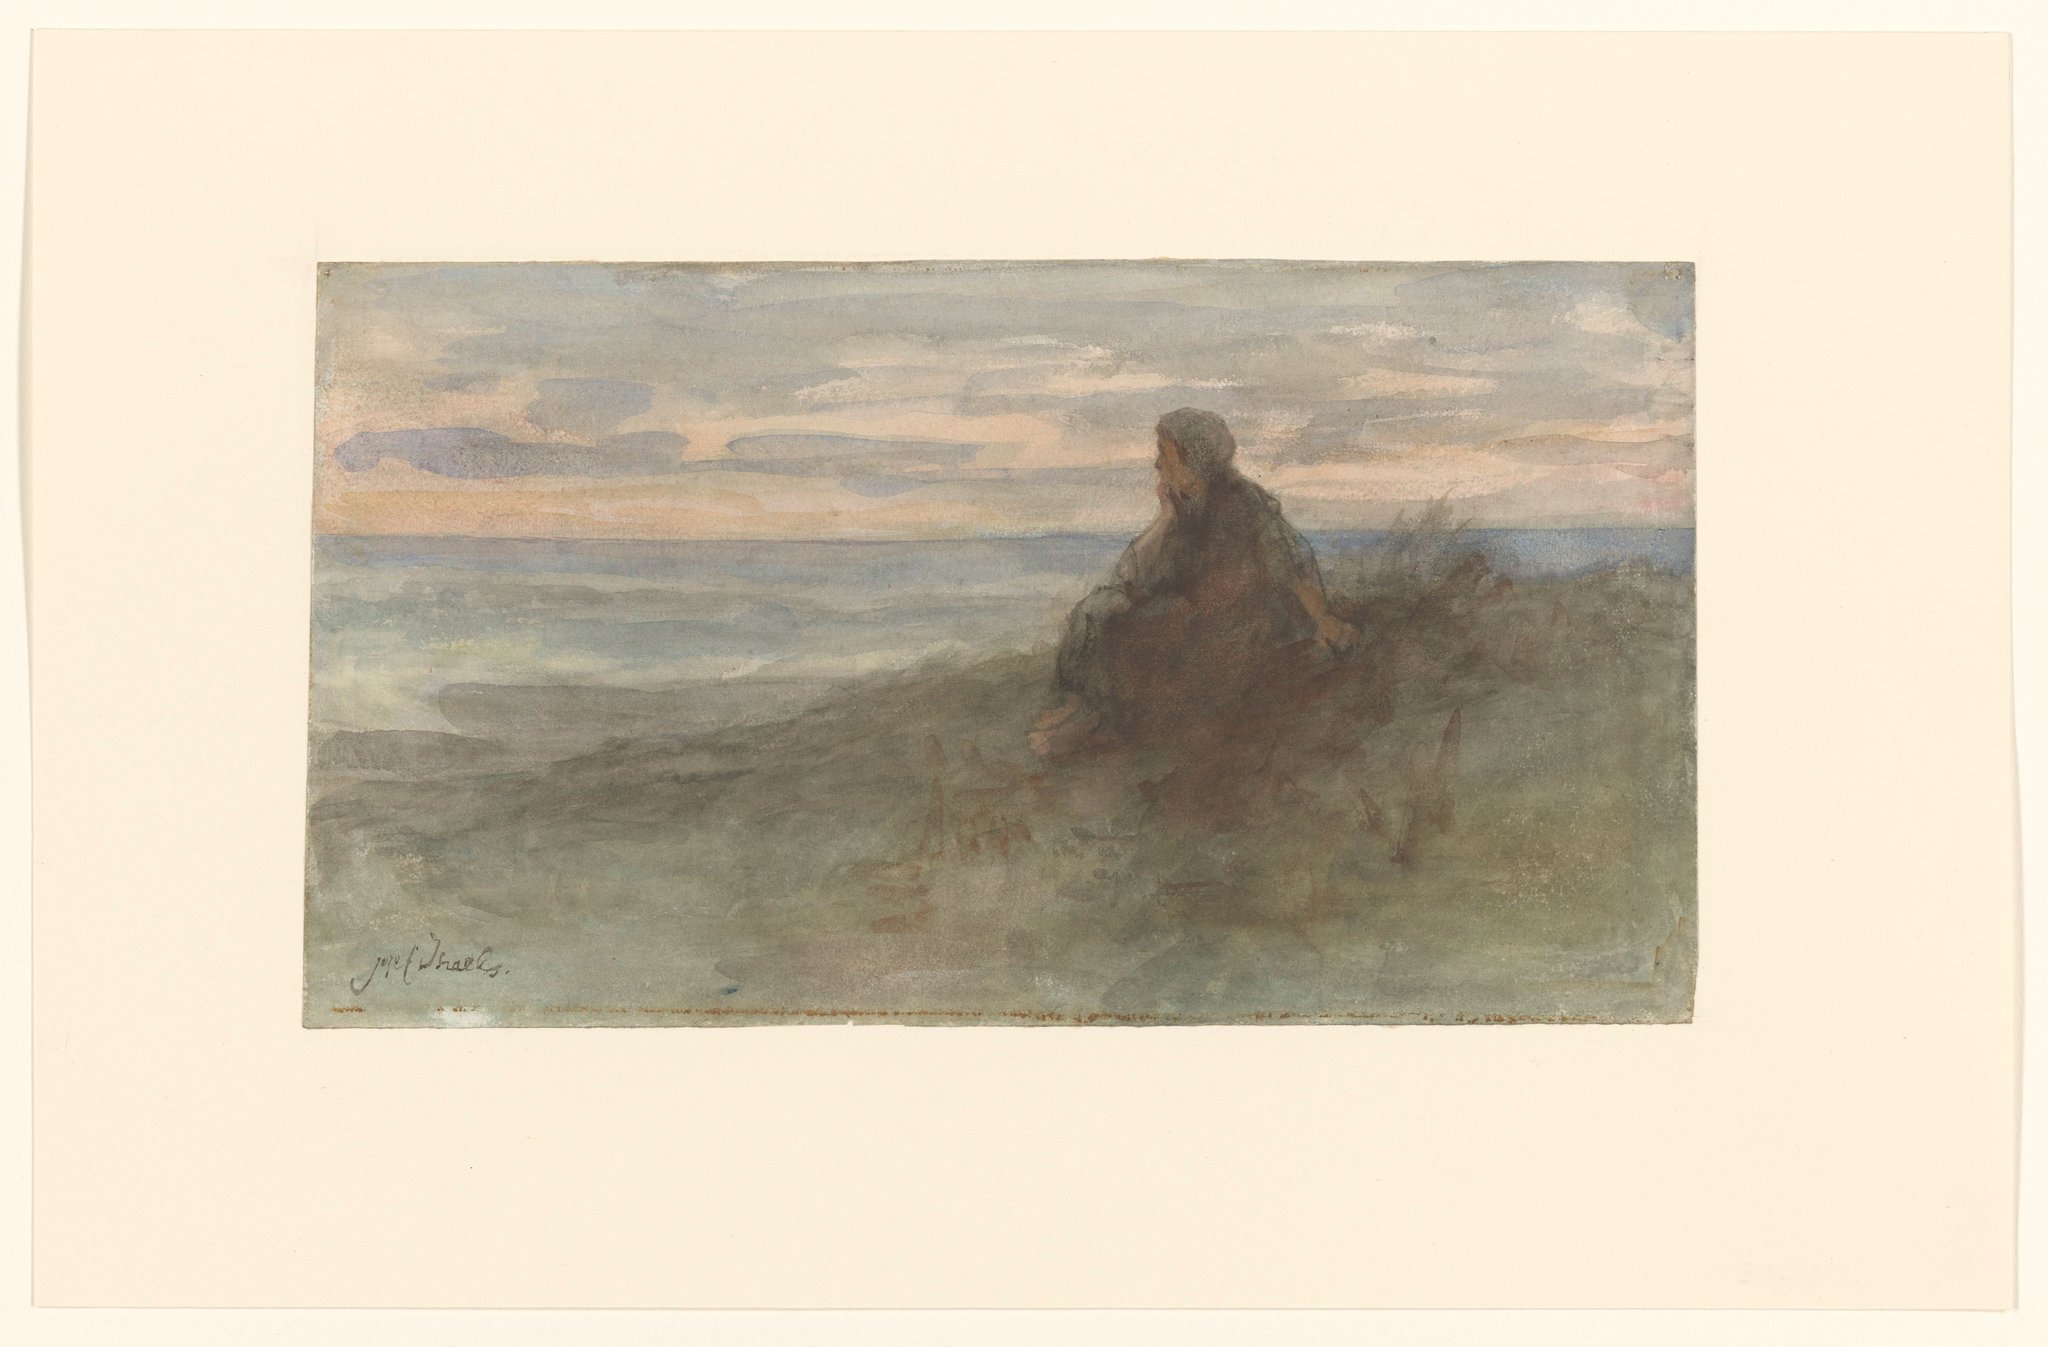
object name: drawing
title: Zittende vrouw op een duin bij zee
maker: jozef israëls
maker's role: draughtsman, painter, print maker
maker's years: 1824-1911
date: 1834-1911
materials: paper, watercolor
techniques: brush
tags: coast